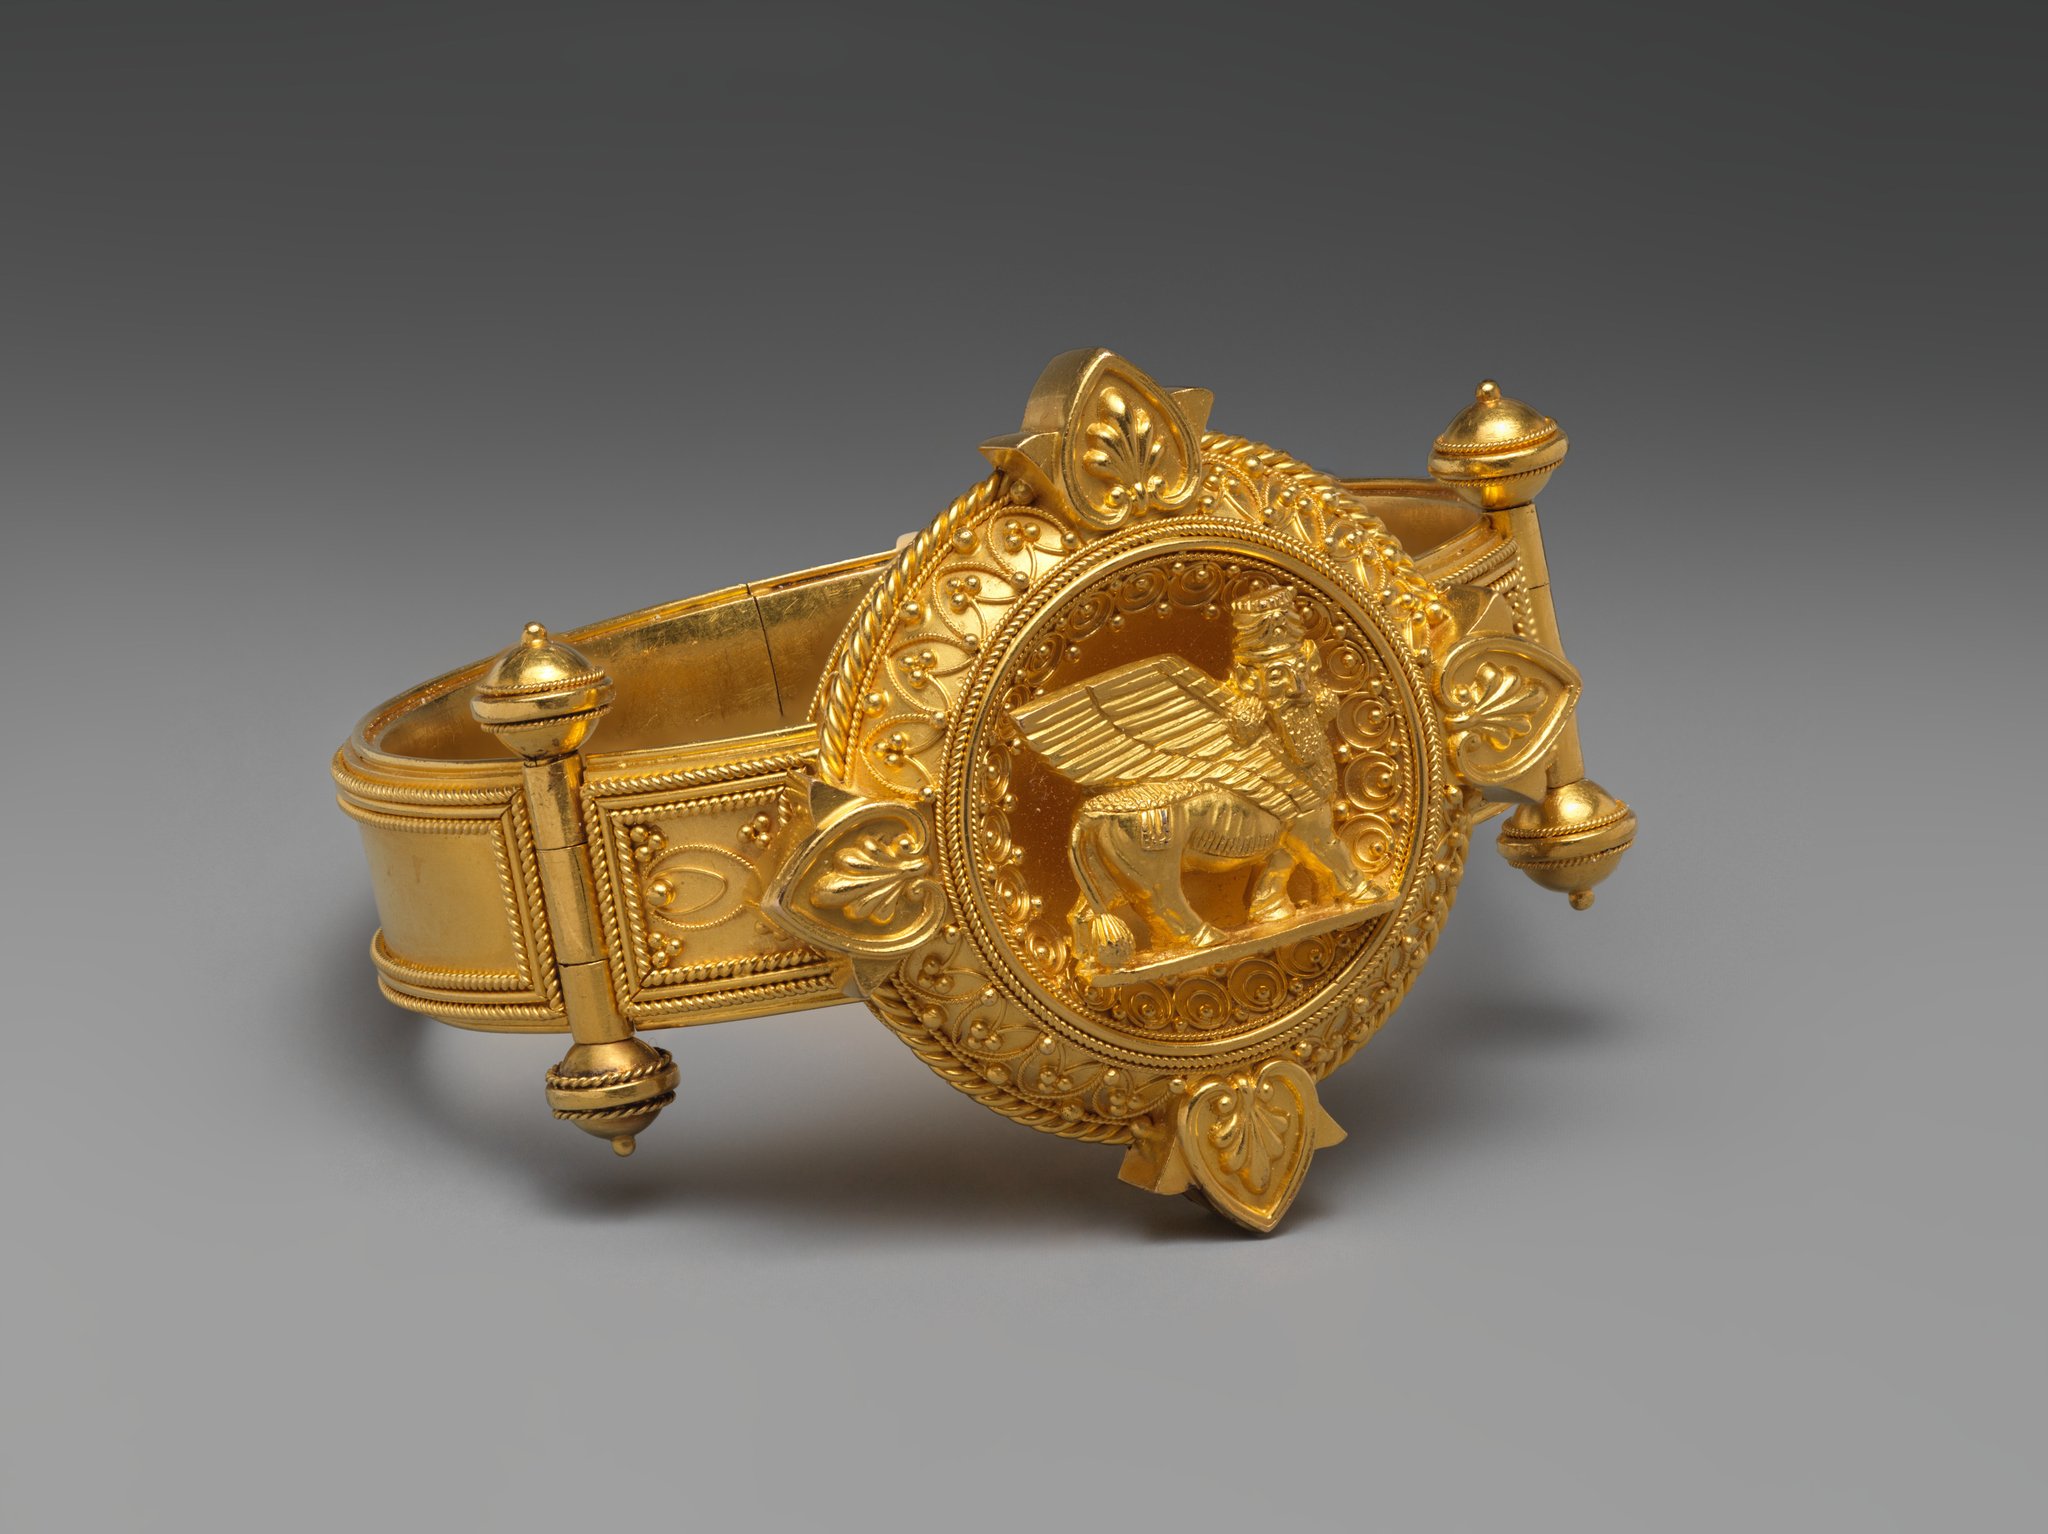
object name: hinged bracelet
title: Hinged bracelet with Assyrian human-headed winged bull medallion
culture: british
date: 1868-1880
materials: gold